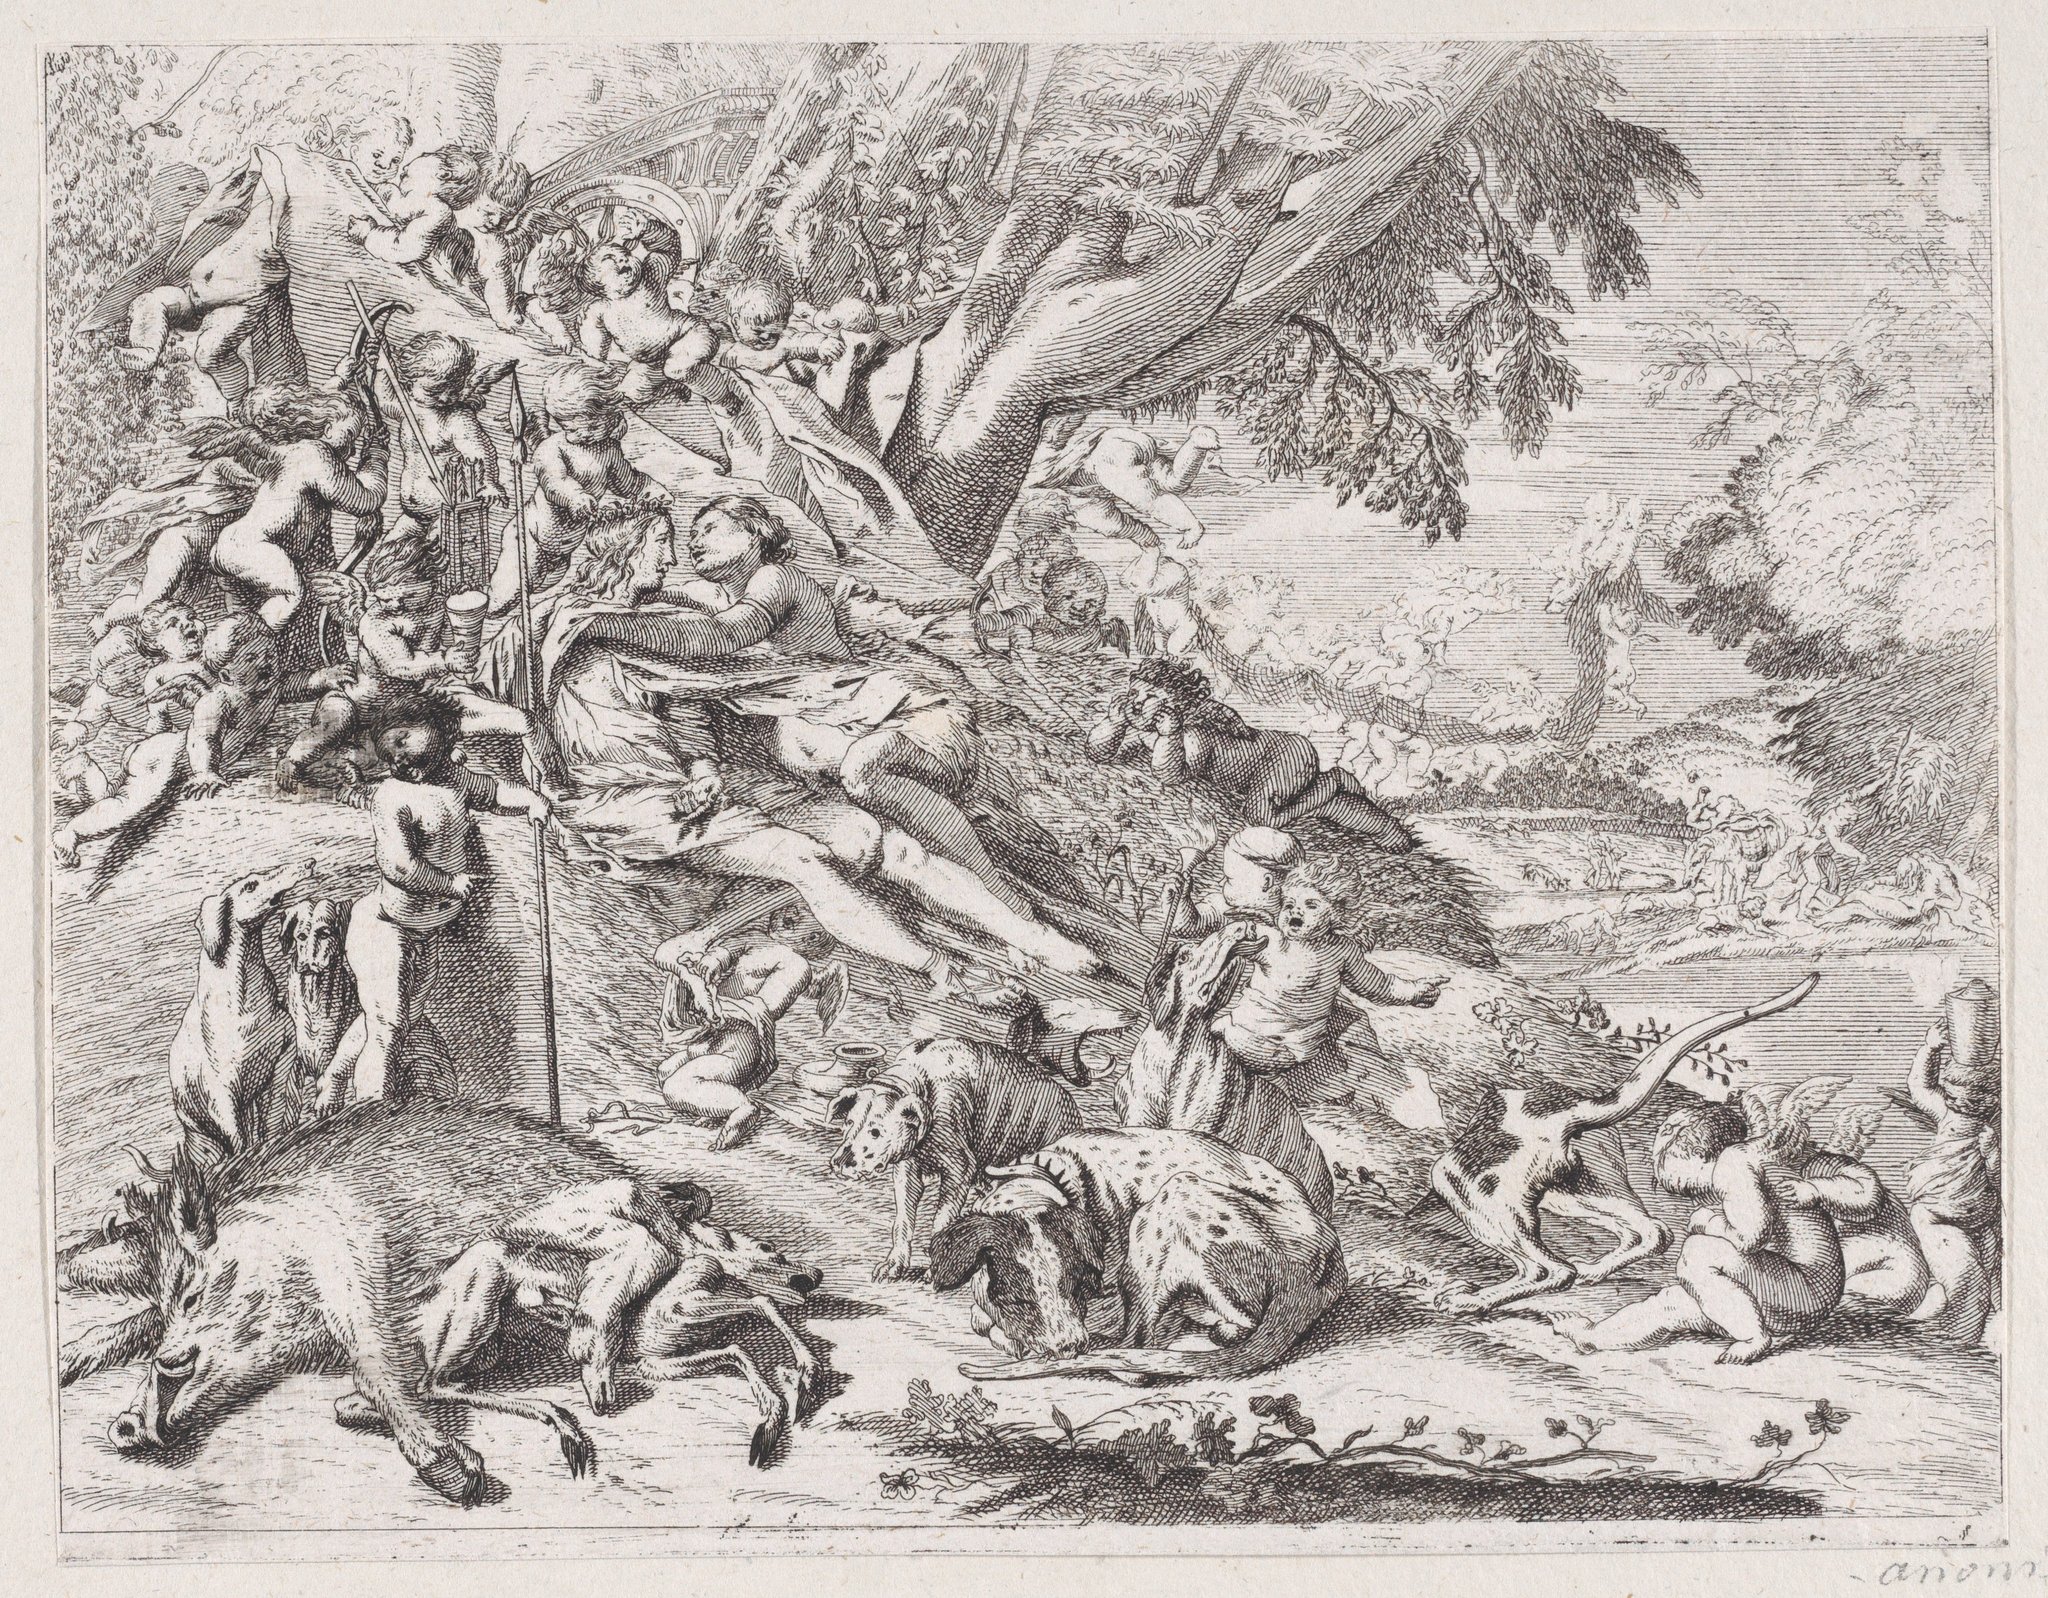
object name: print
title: Venus and Adonis embracing after the hunt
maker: anonymous, 17th century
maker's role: artist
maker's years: 1600-1700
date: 1650-1700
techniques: etching